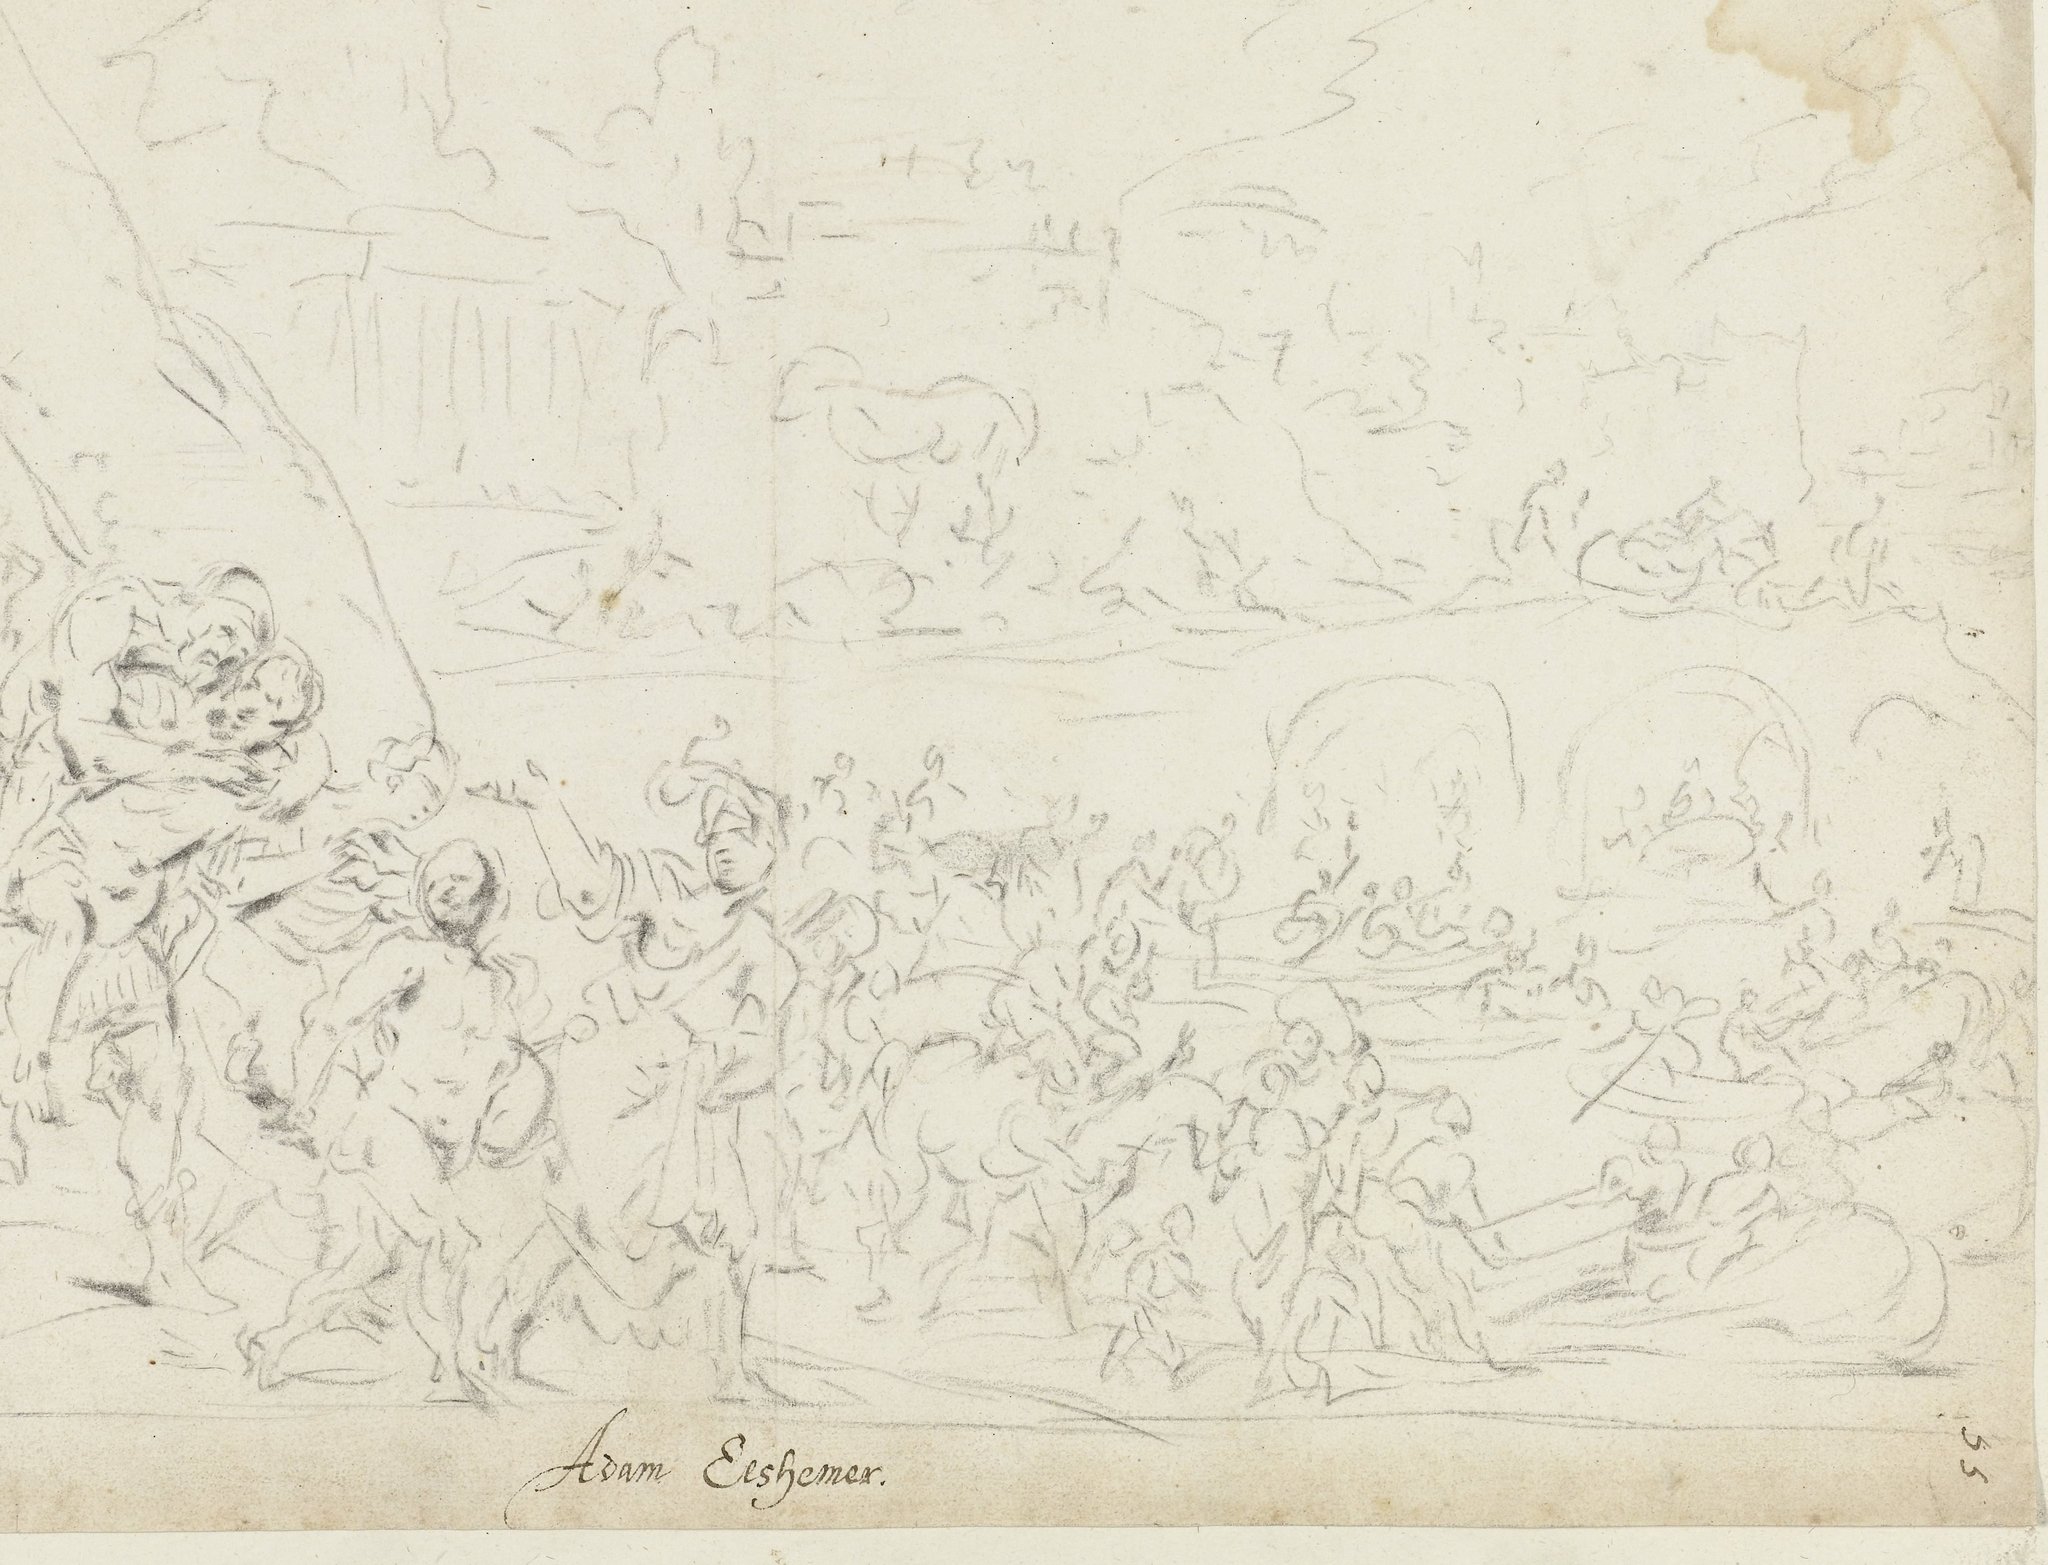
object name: album leaf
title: Aeneas draagt zijn vader Anchises uit het brandende Troje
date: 1642-1653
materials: chalk, paper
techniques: pasting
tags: (story of) aeneas, (story of) anchises, the fall of troy; troy burning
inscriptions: number: ‘55’, inscription: ‘Adam Eishemer.’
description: Het originele schilderij bevindt zich in de collectie van de Alte Pinakothek in München.